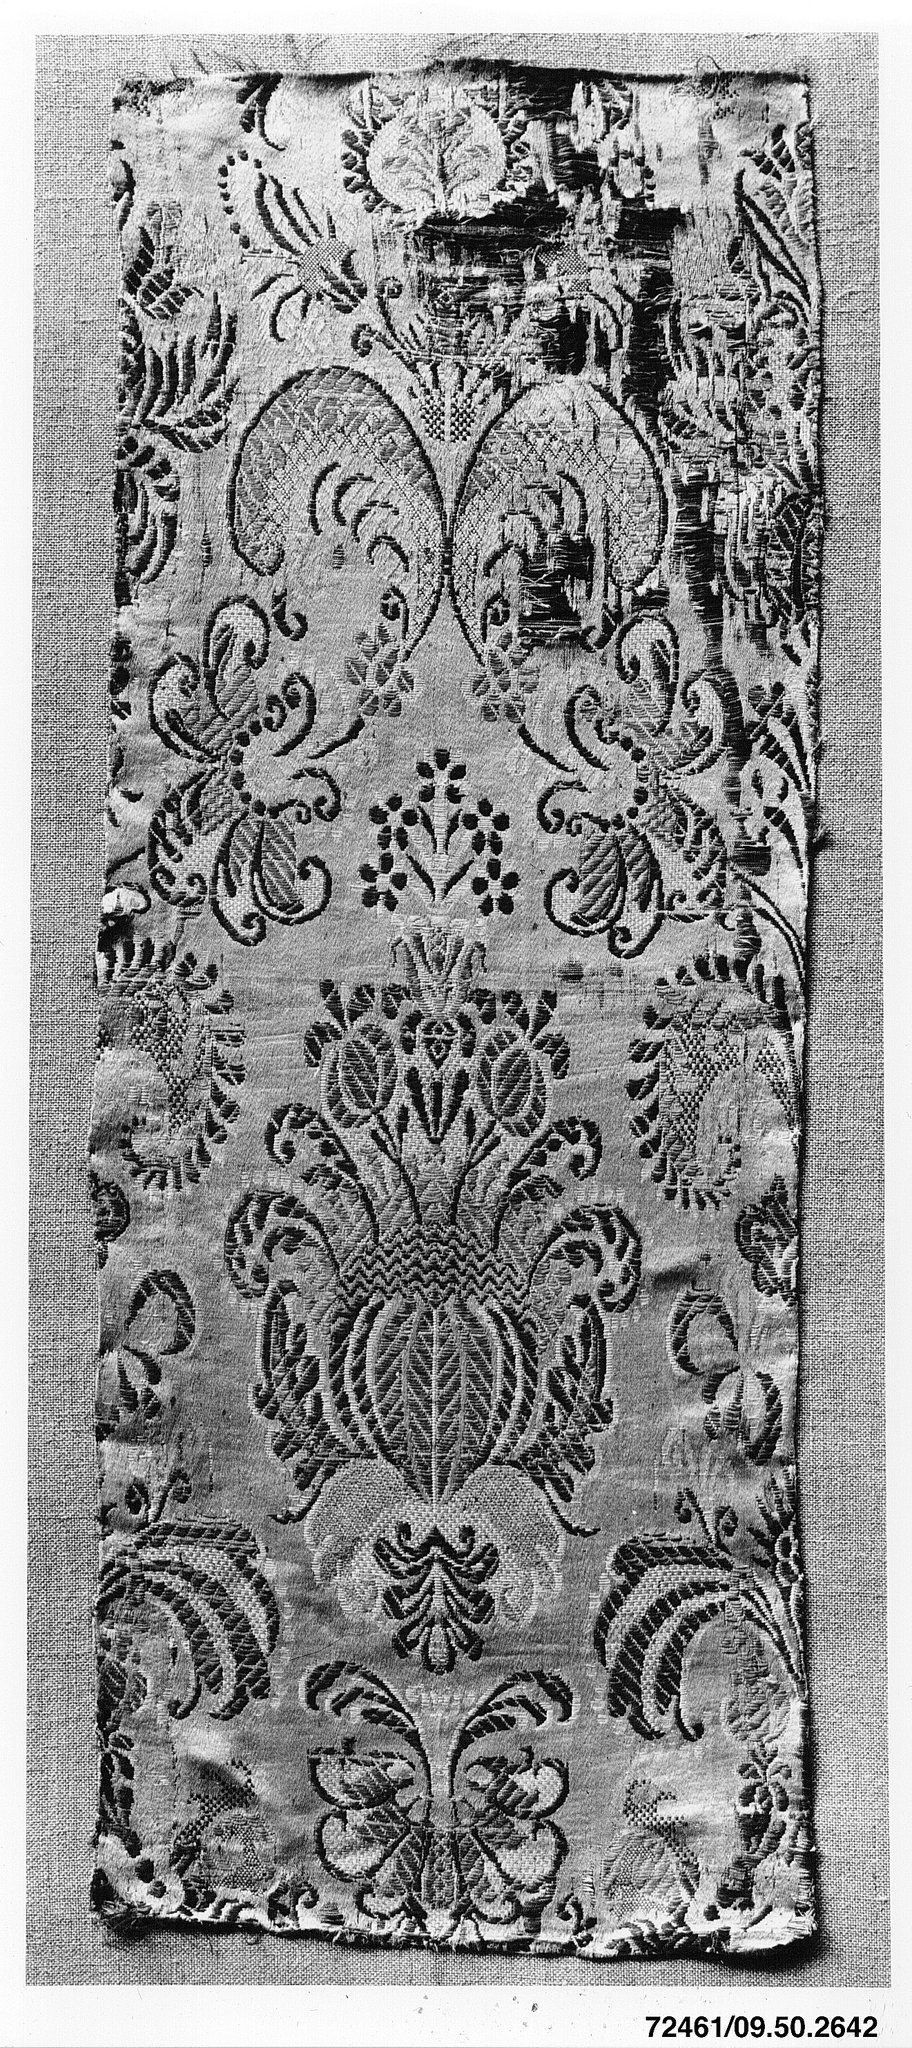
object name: piece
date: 1650-1670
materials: silk